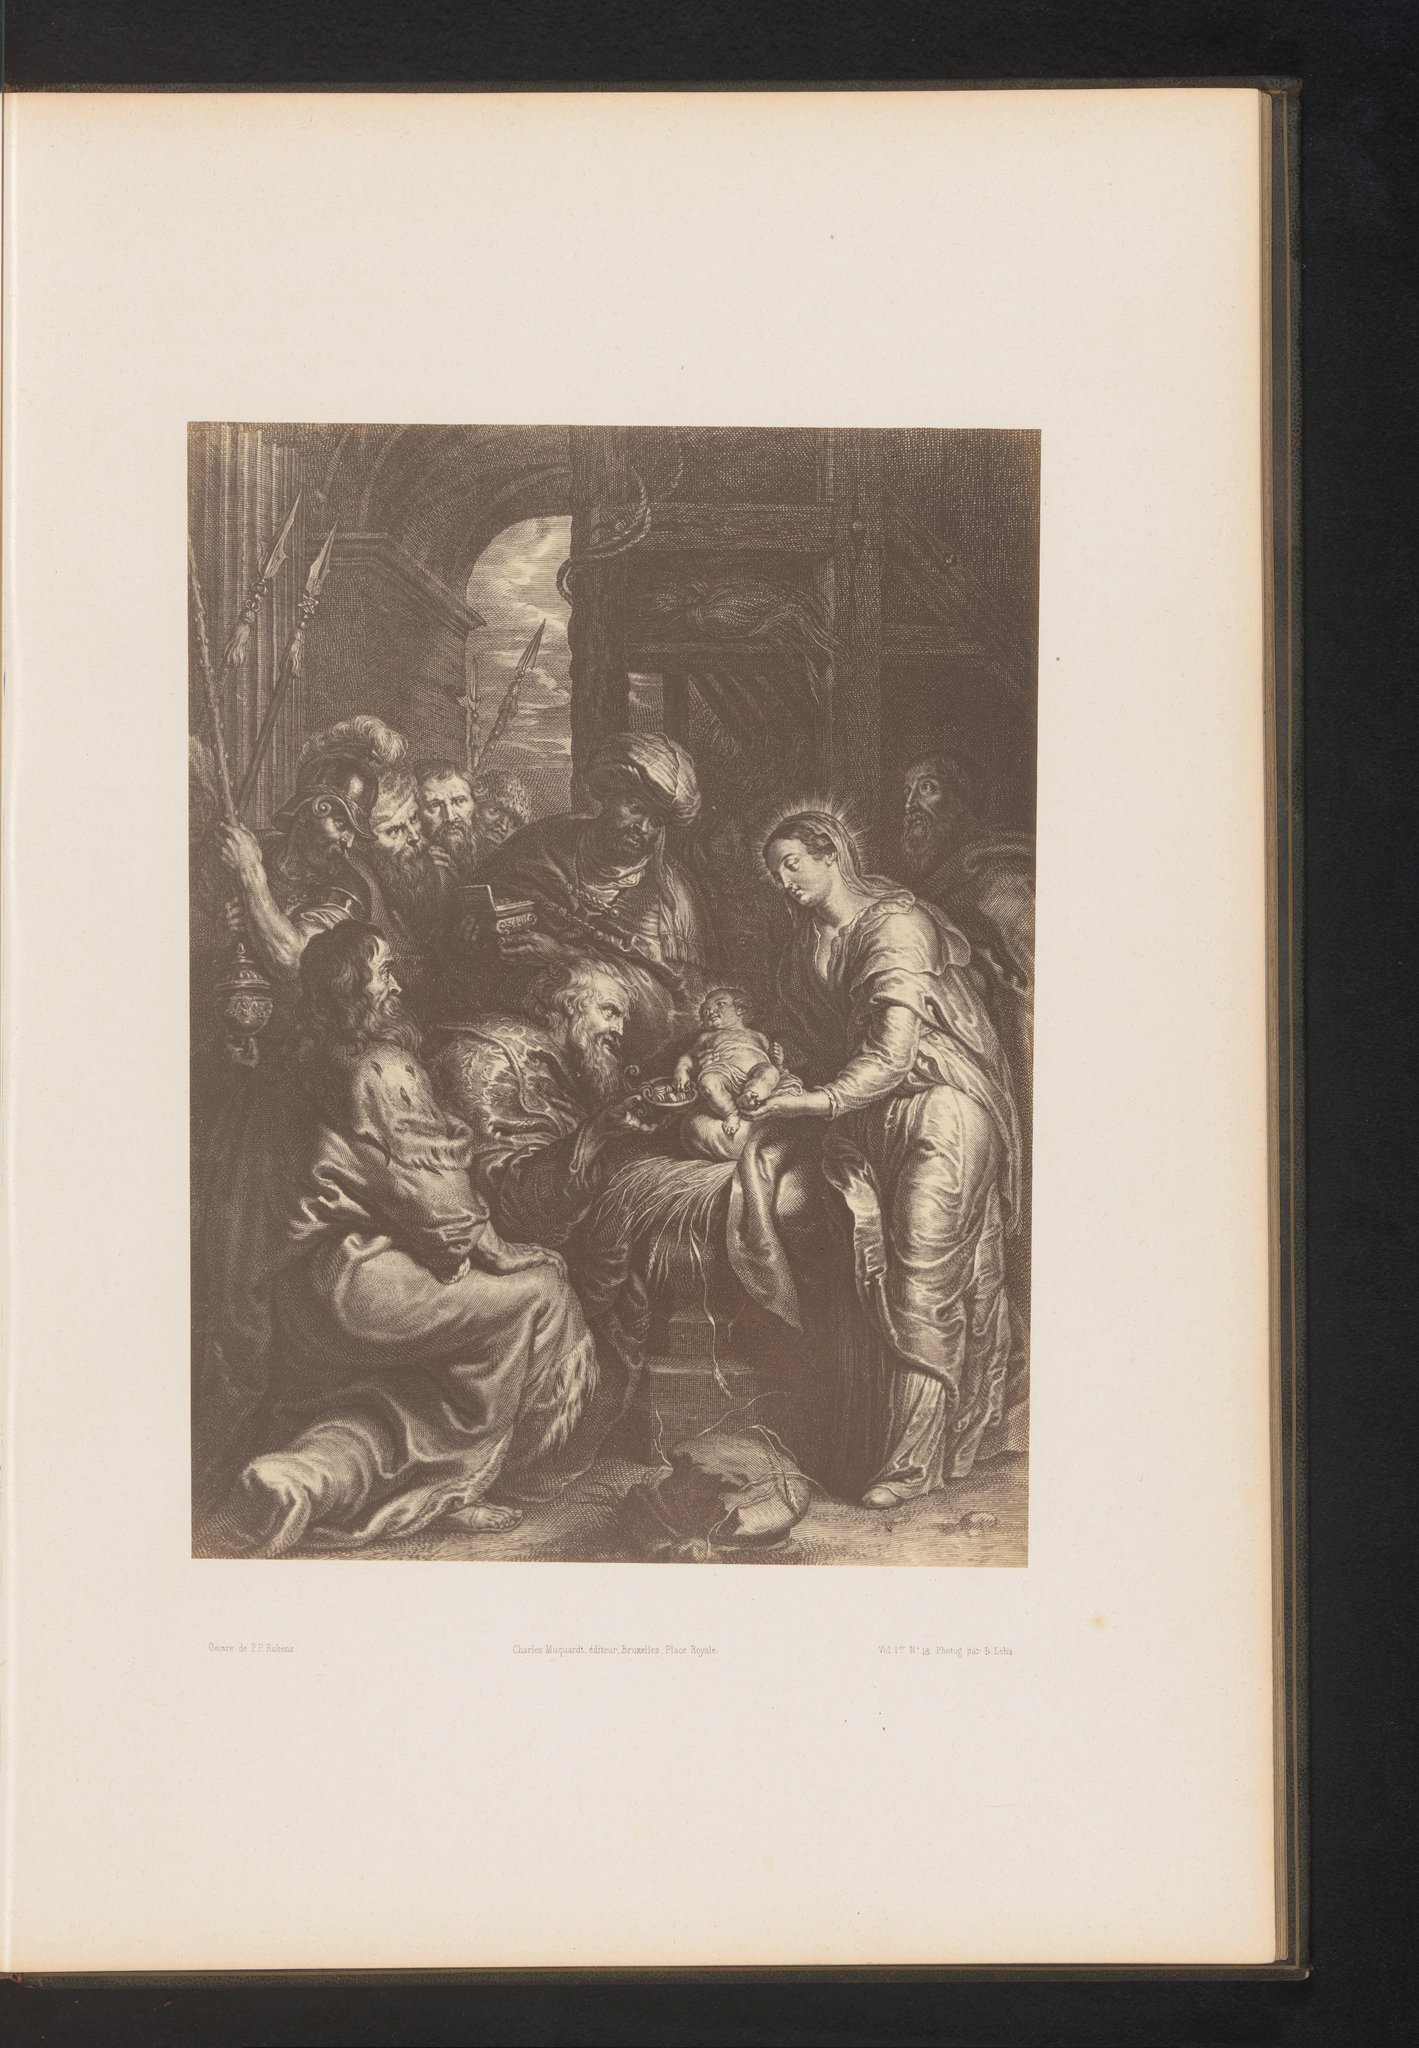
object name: reproduction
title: Oeuvre de P.P. Rubens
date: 1853-1858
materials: photographic support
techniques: albumen print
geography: brussels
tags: adoration of the kings: the wise men present their gifts to the christ-child (gold, frankincense and myrrh)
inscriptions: number: ‘Vol. 1er. No 13.’